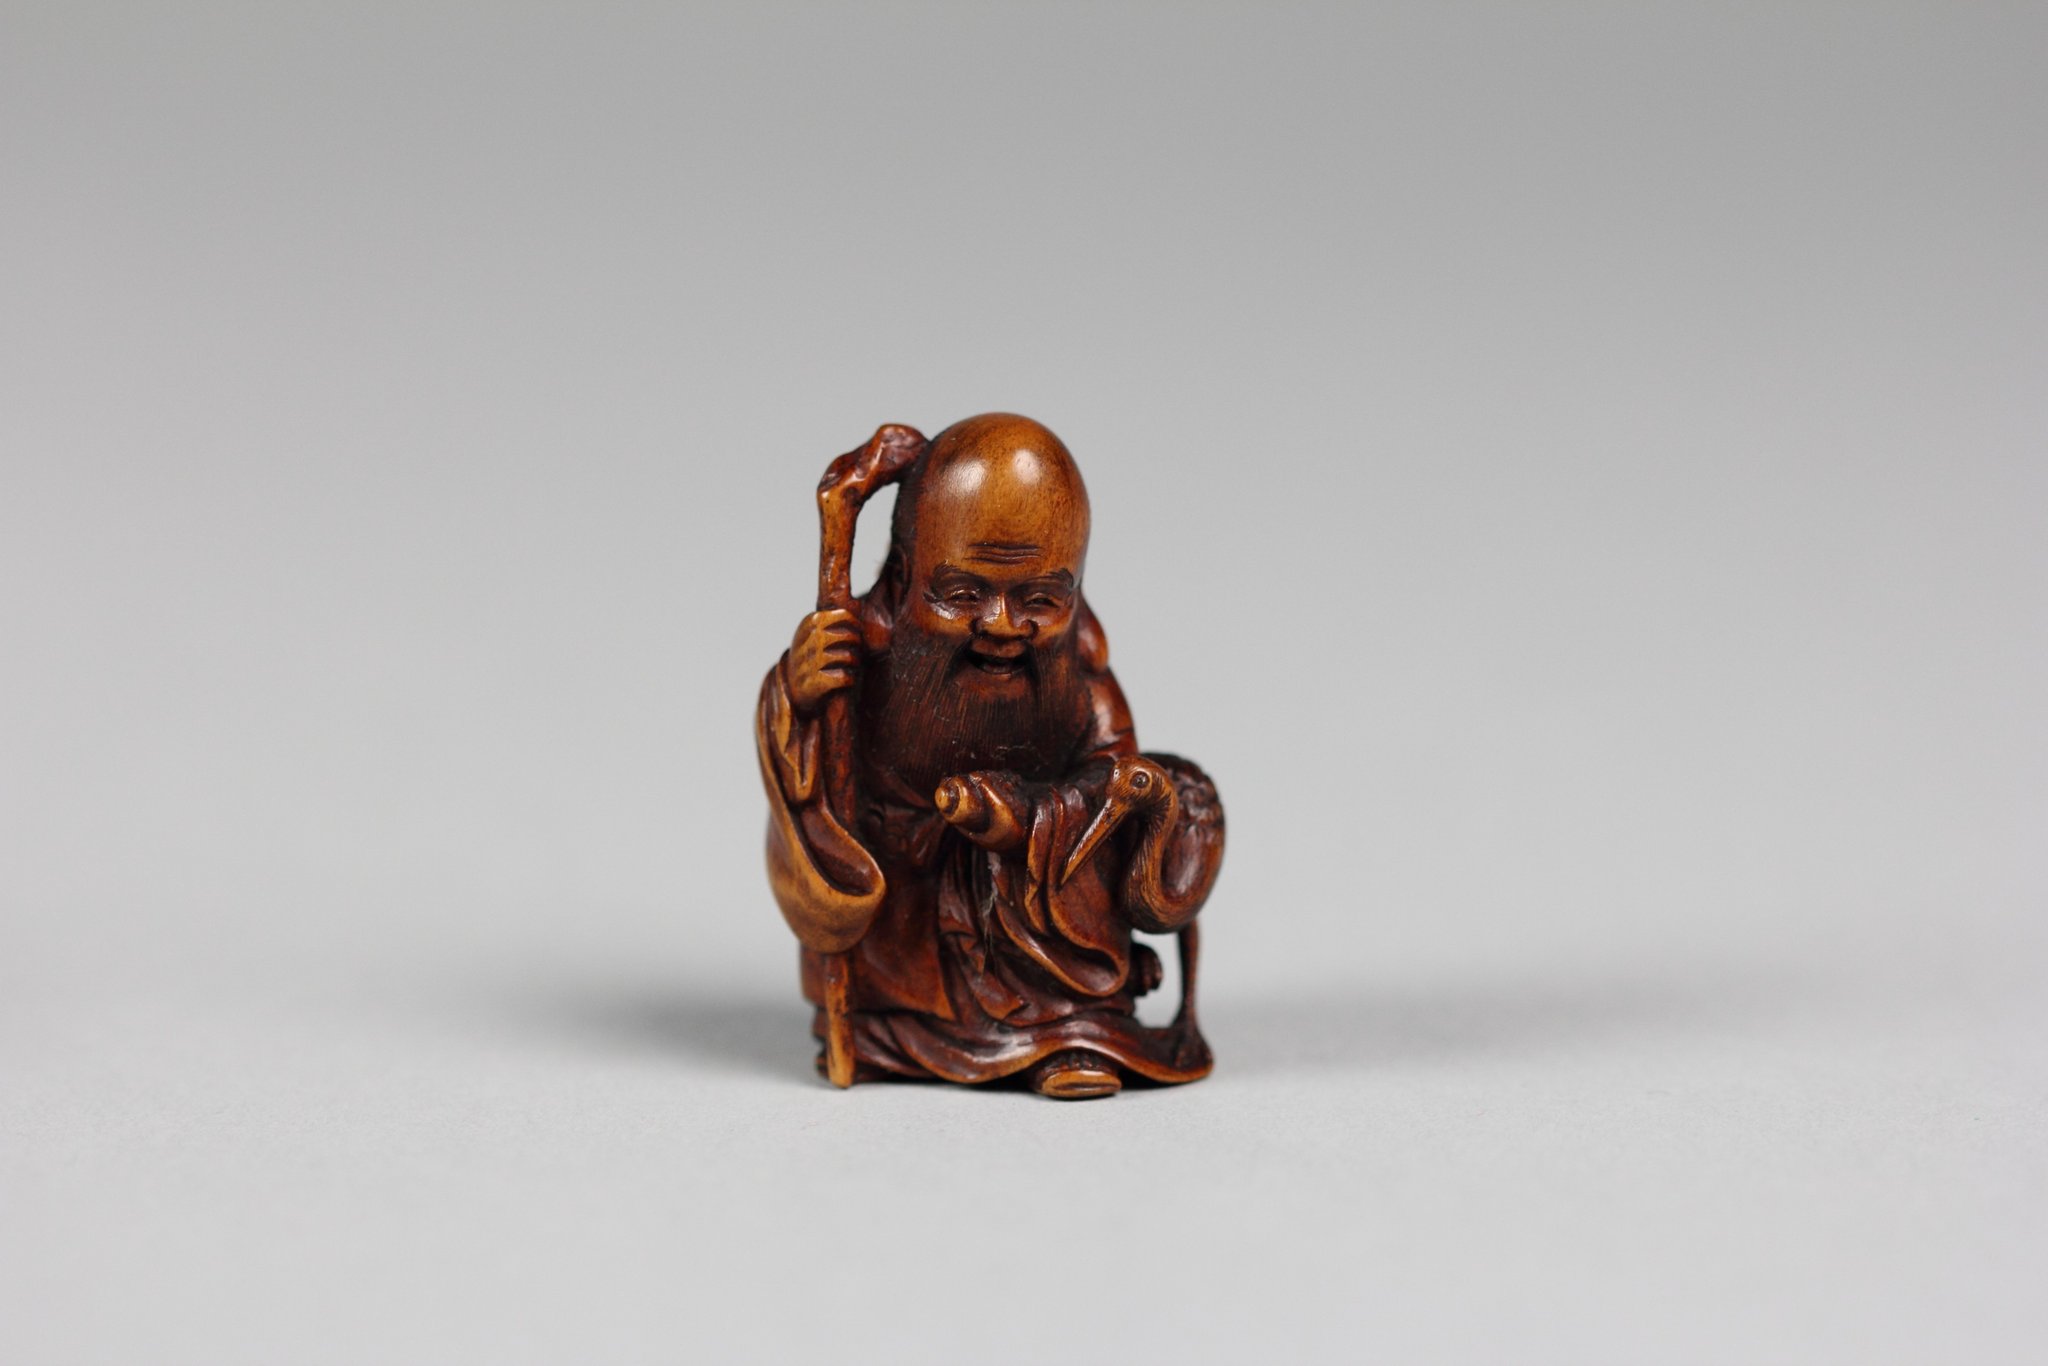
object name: netsuke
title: Netsuke of Fukurokujin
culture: japanese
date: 1801-1900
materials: wood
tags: human figures